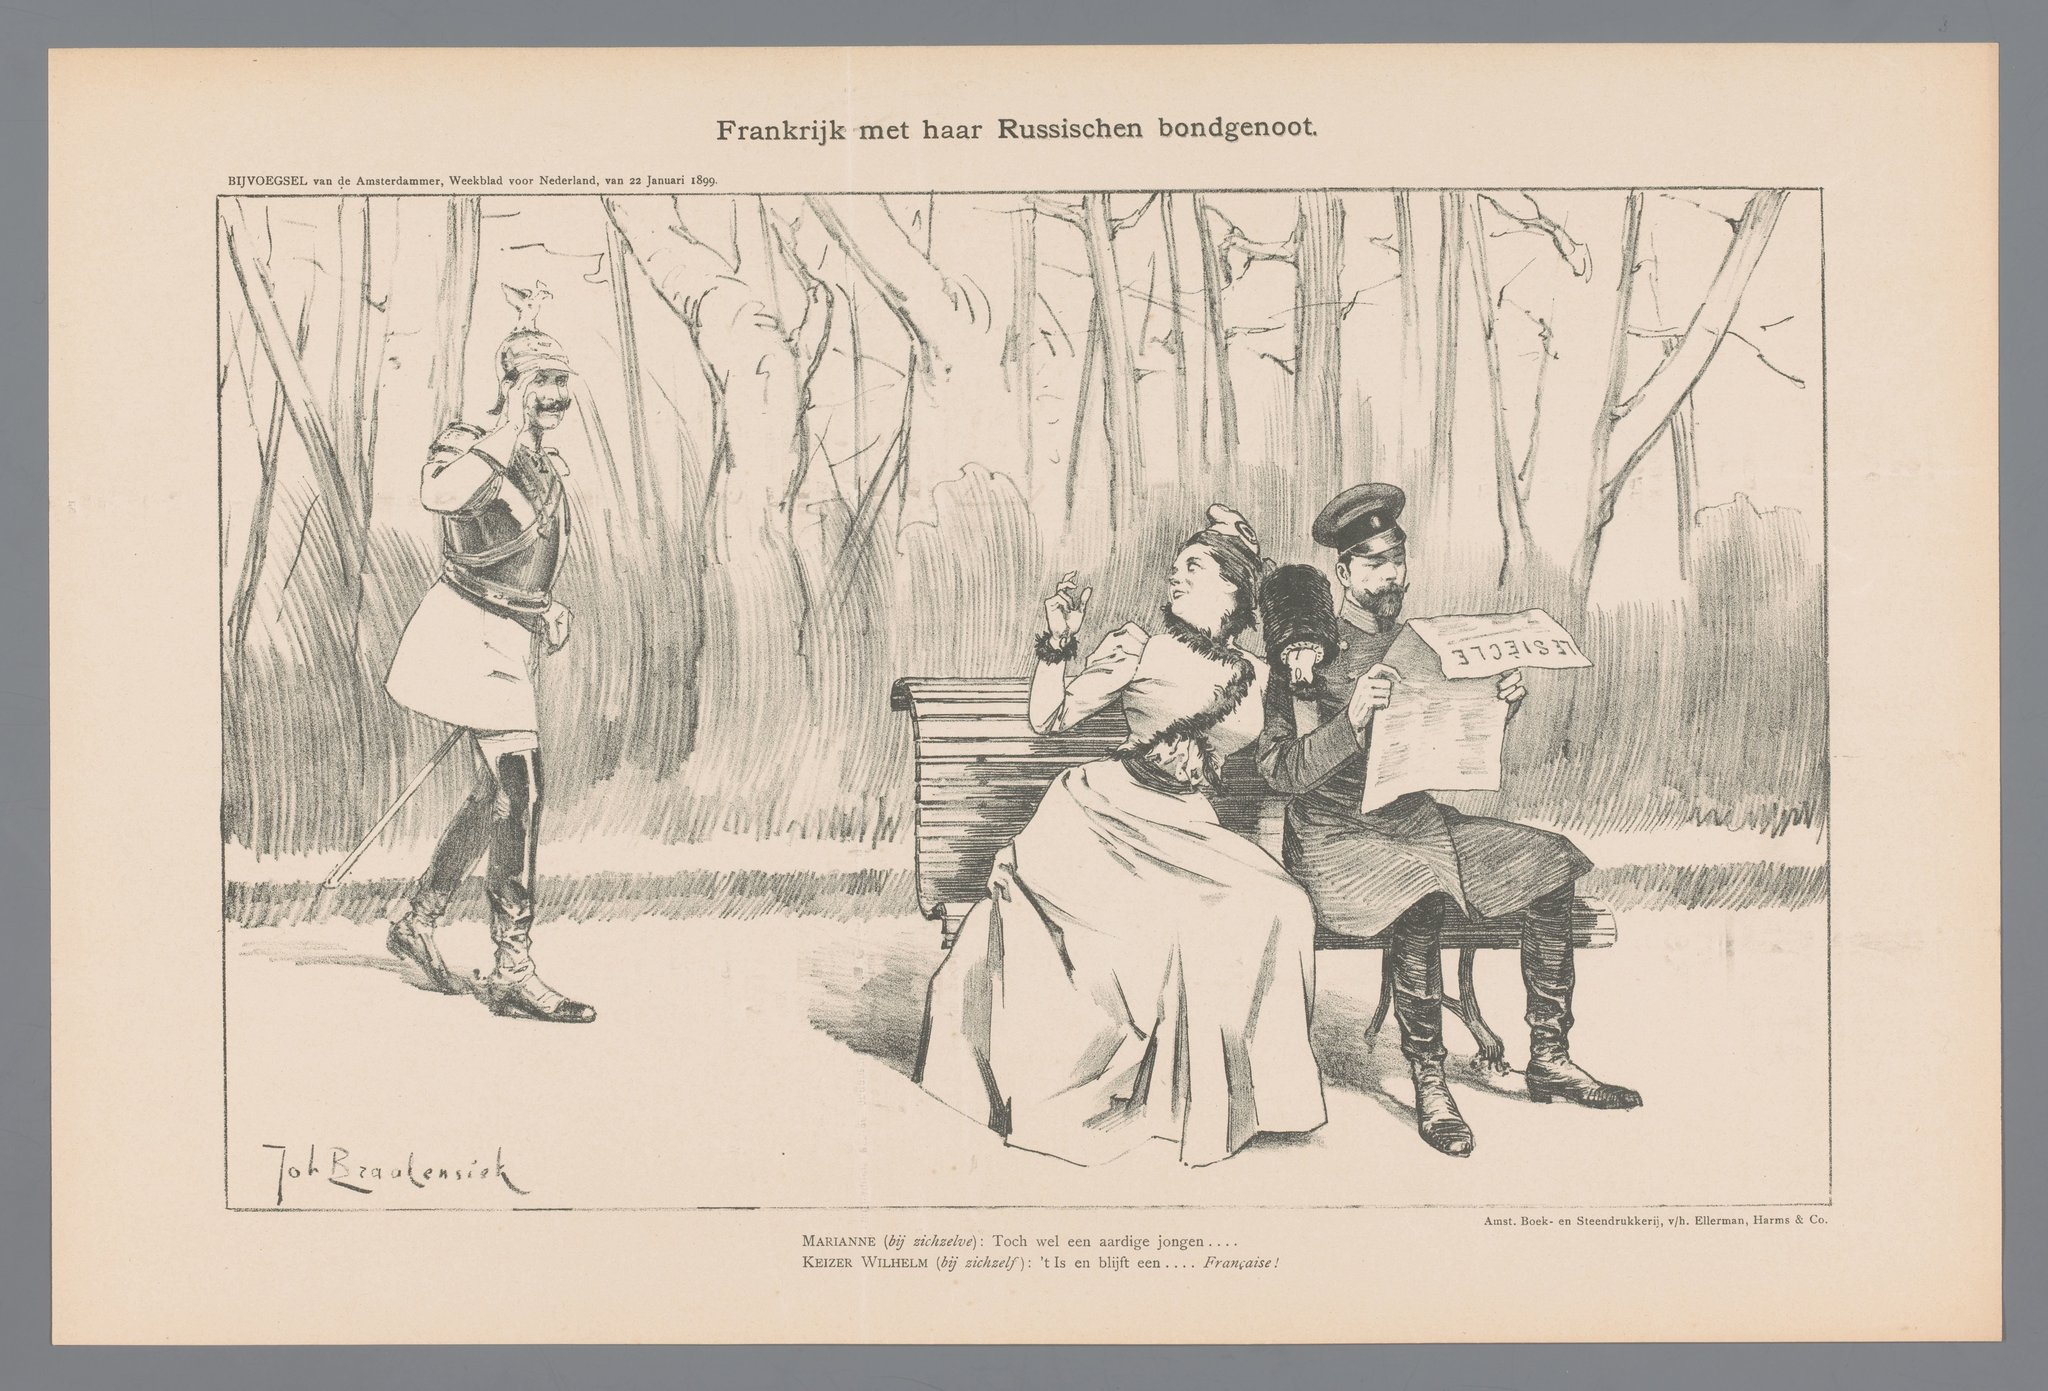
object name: cartoon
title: Frankrijk met haar Russischen bondgenoot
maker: johan braakensiek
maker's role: draughtsman, print maker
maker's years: 1858-1940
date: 1899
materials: paper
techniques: lithograph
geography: amsterdam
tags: wilhelm ii (keizer van duitsland), historical persons, emperor, personifications of countries, nations, states, districts, etc. (+ nation; national), politics, political caricatures and satires, russia, france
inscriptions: date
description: Prent uit het bijvoegsel van: De Amsterdammer. Weekblad voor Nederland, 21 januari 1899.